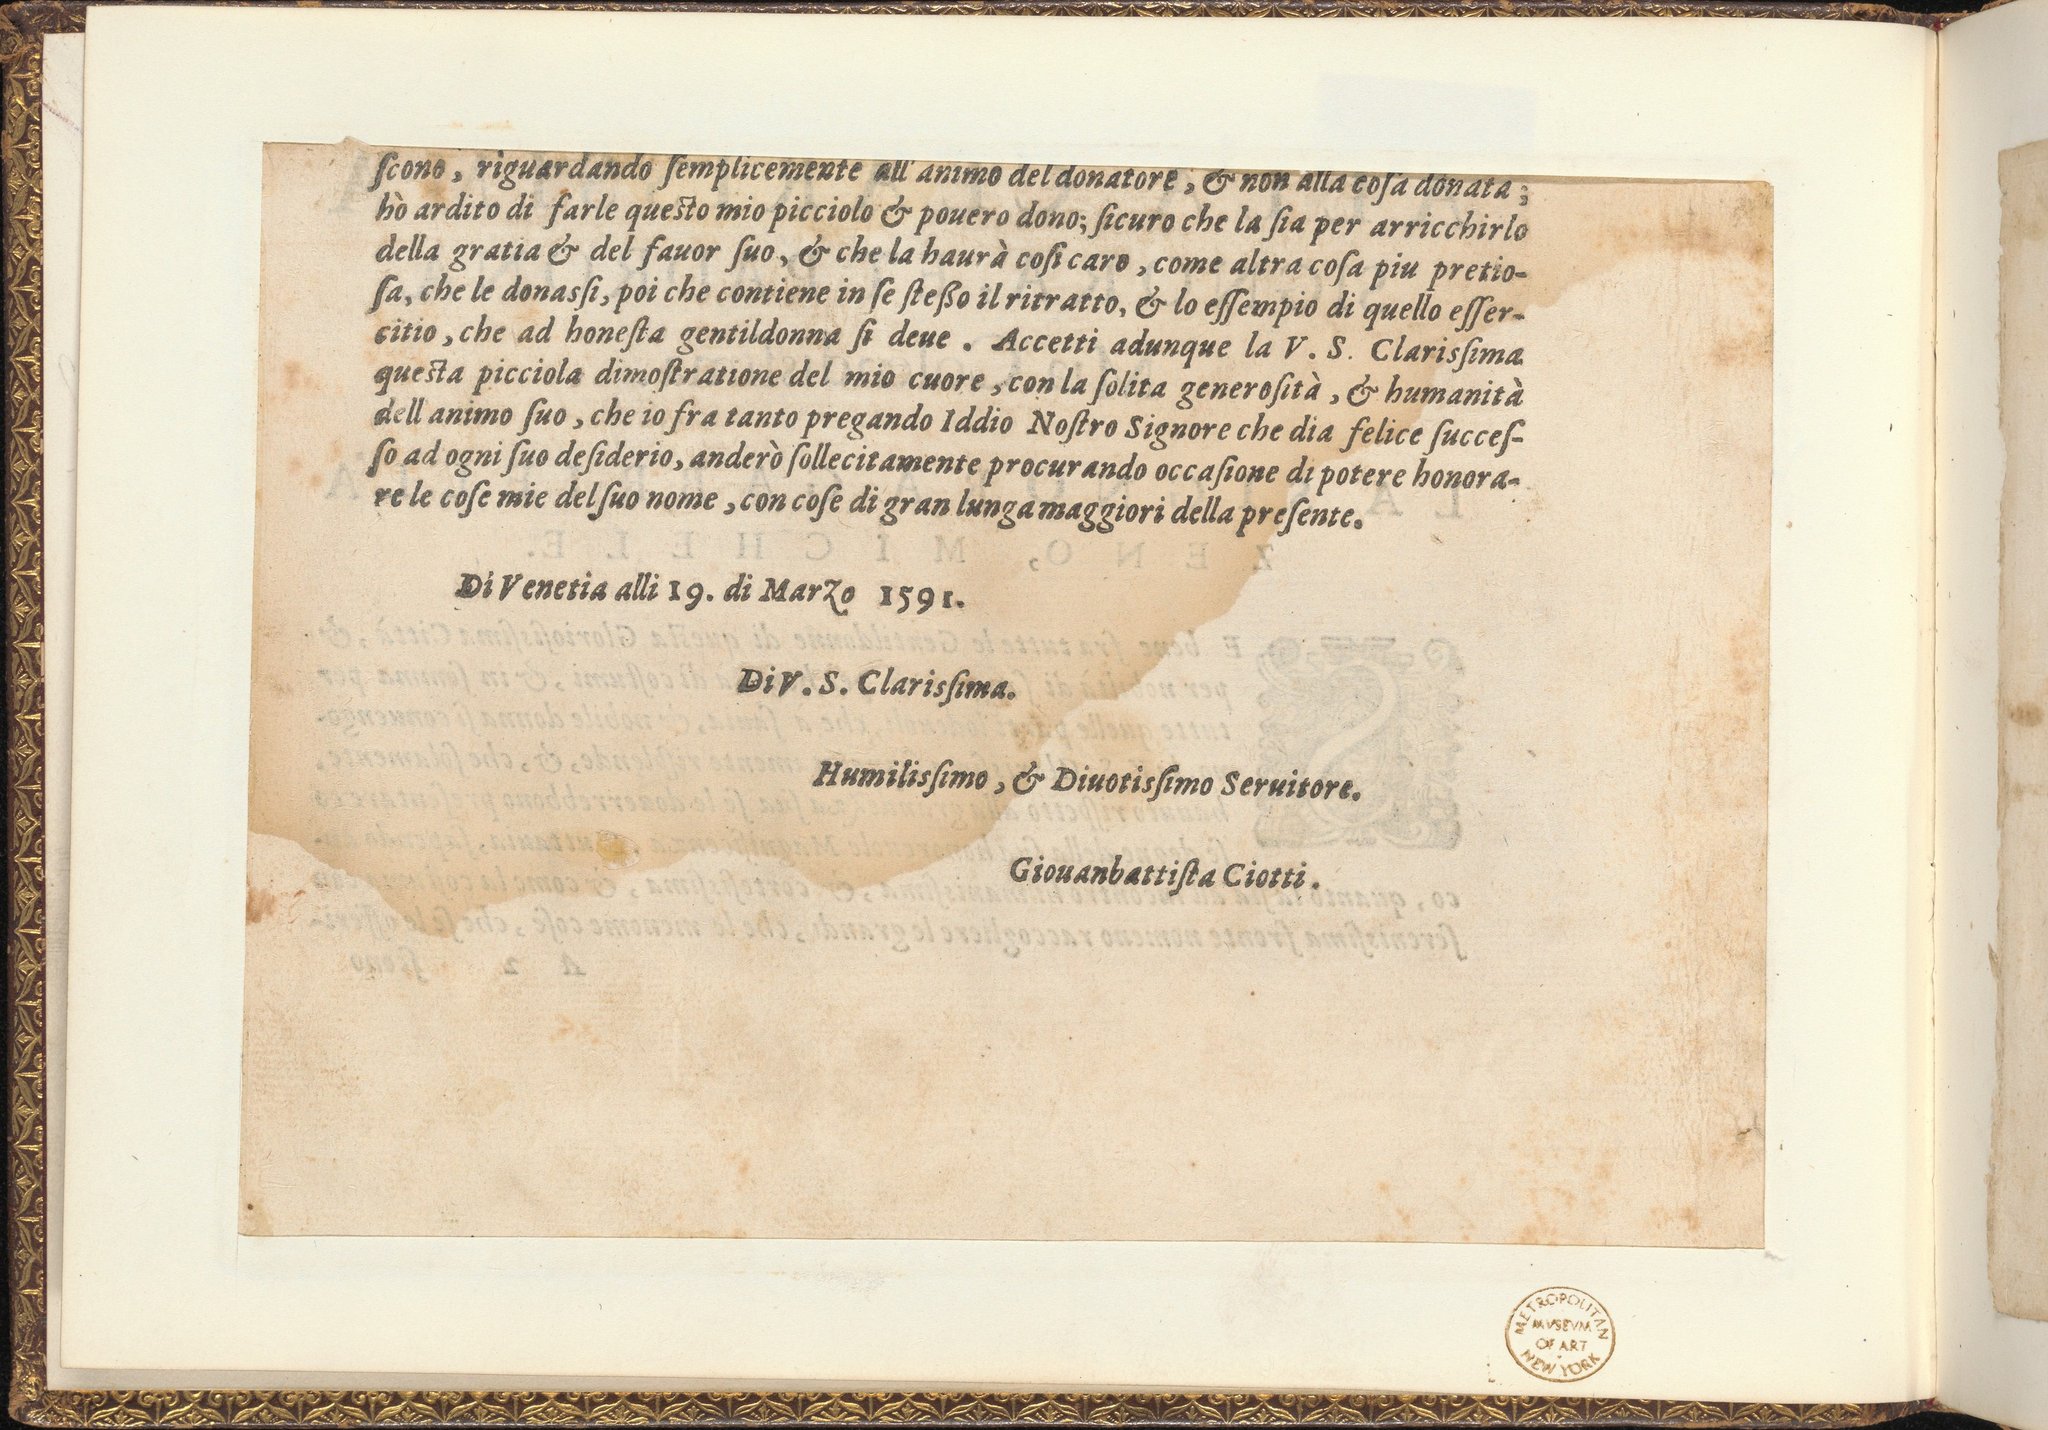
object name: book print ornament architecture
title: Prima parte de' fiori, page 2 (verso)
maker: giovanni battista ciotti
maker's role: author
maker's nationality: italian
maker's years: 1555-1659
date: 1591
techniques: woodcut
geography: italy